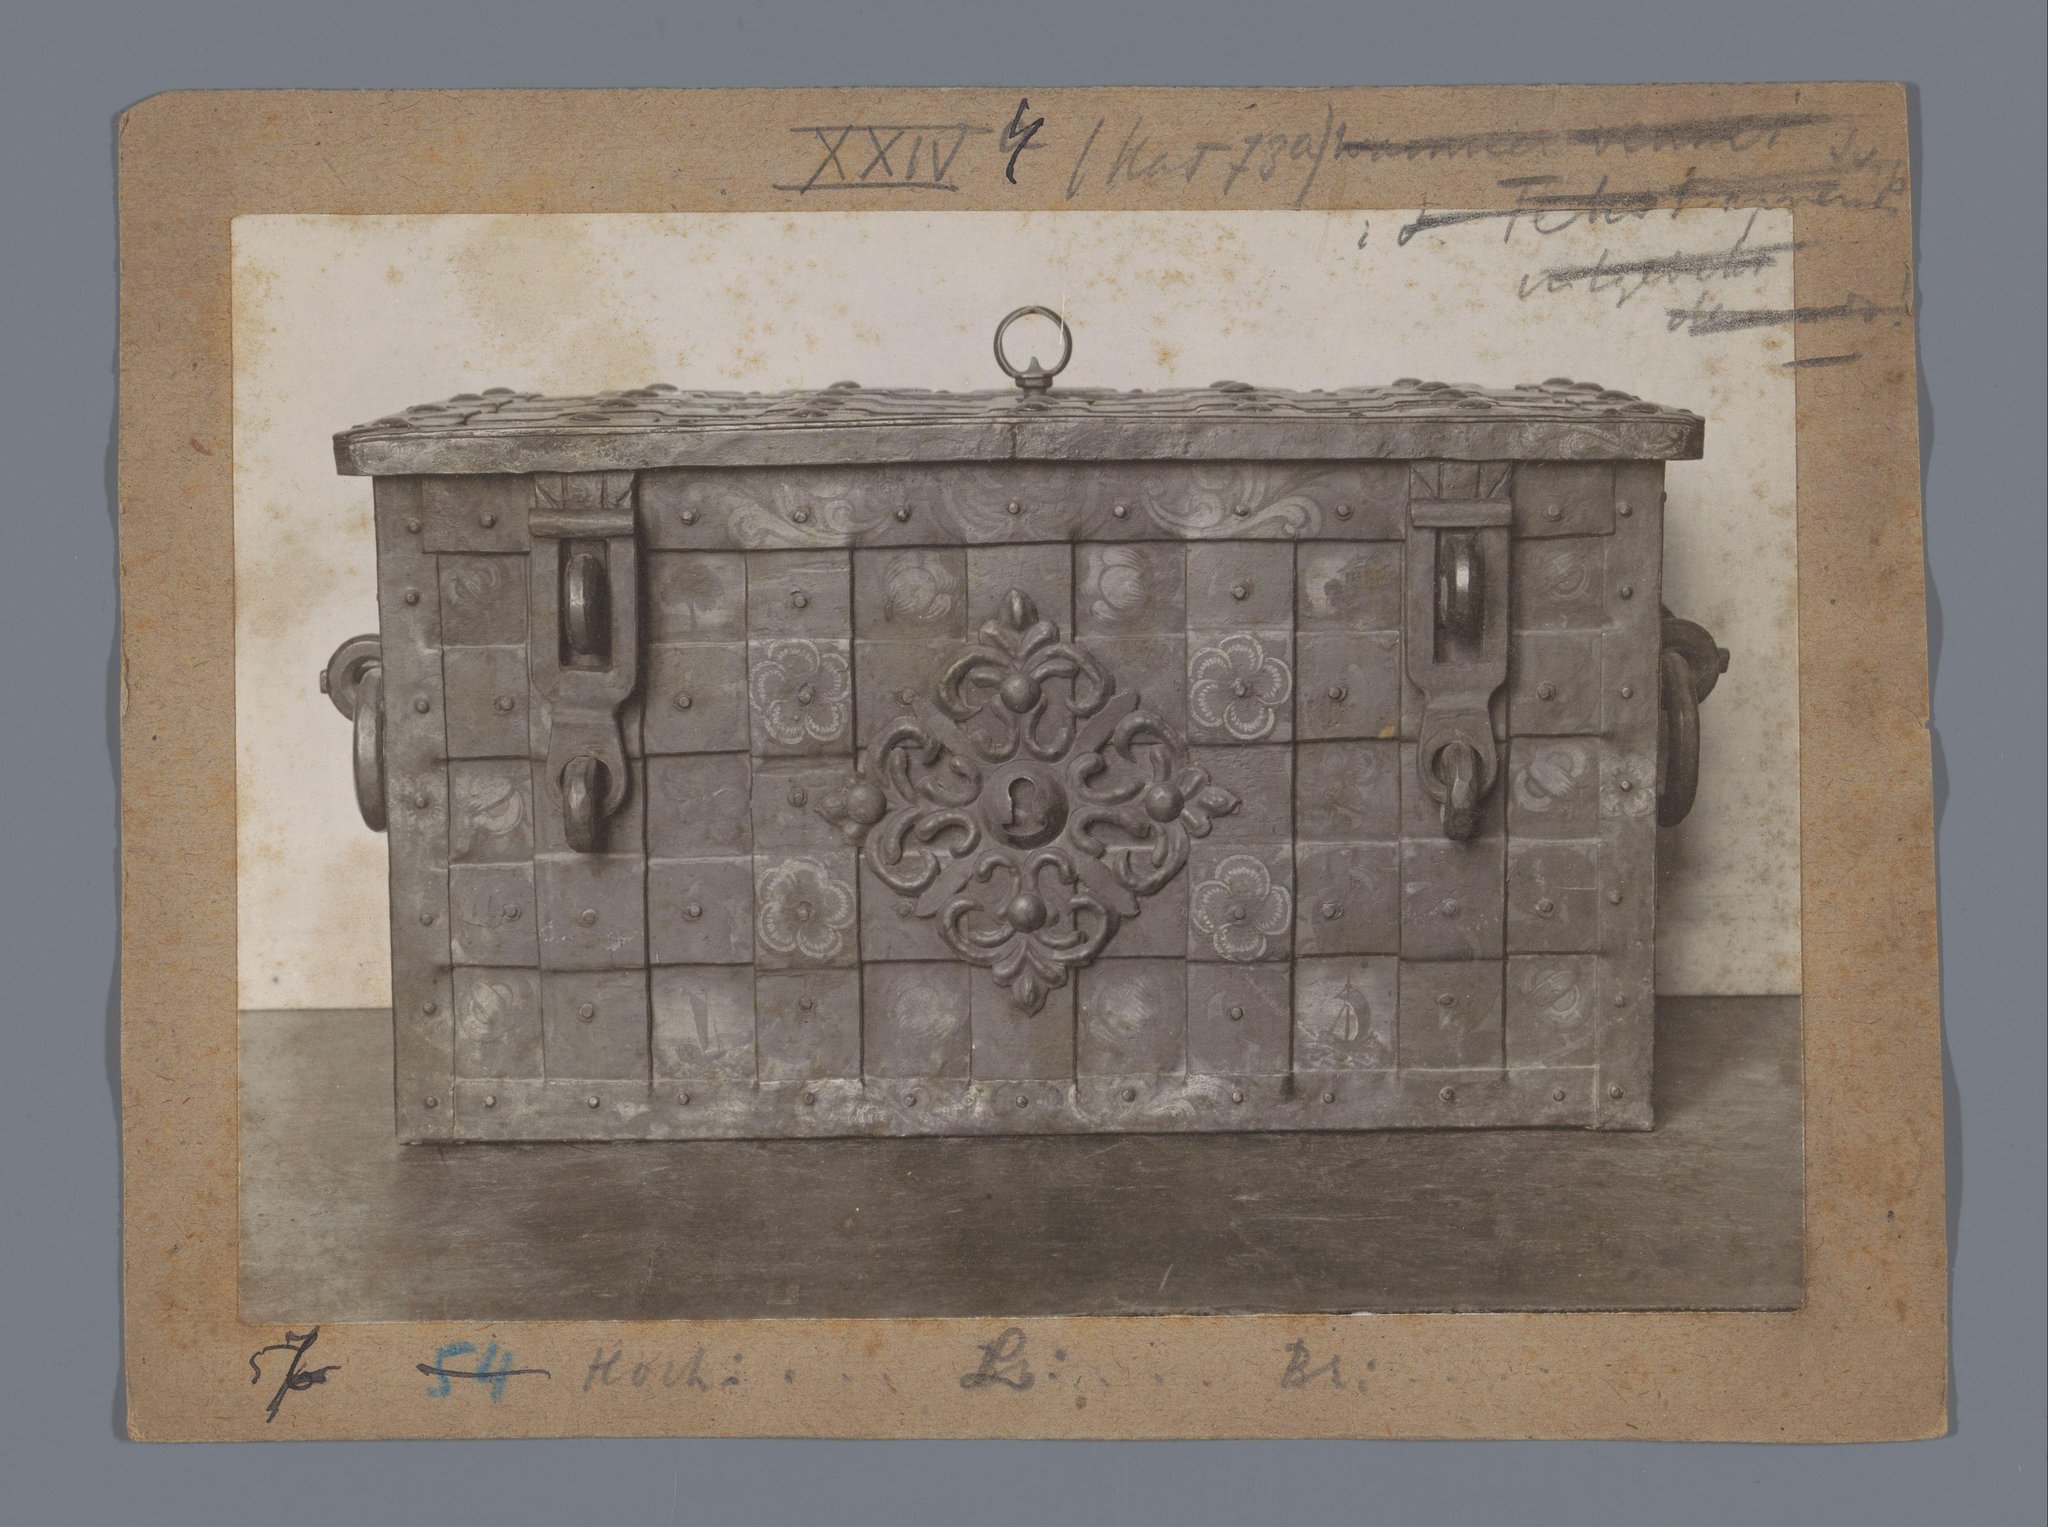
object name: photograph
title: Kist met fleur-de-lys decoraties rond het sleutelgat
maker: Anonymous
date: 1875-1900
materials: photographic support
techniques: matte daylight collodion silver print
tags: fleur-de-lis ~ ornament, chest, coffer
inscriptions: collector's mark: ‘Instituut voor kunst-nijverheidsonderwijs Gabriël Metsustraat No. 16, Amsterdam’, number: ‘XXXIV 4 (Kat 73a)’, collector's mark: ‘Kunstnijverheidschool Quellinus Amsterdam Frans Halsstraat 14.’